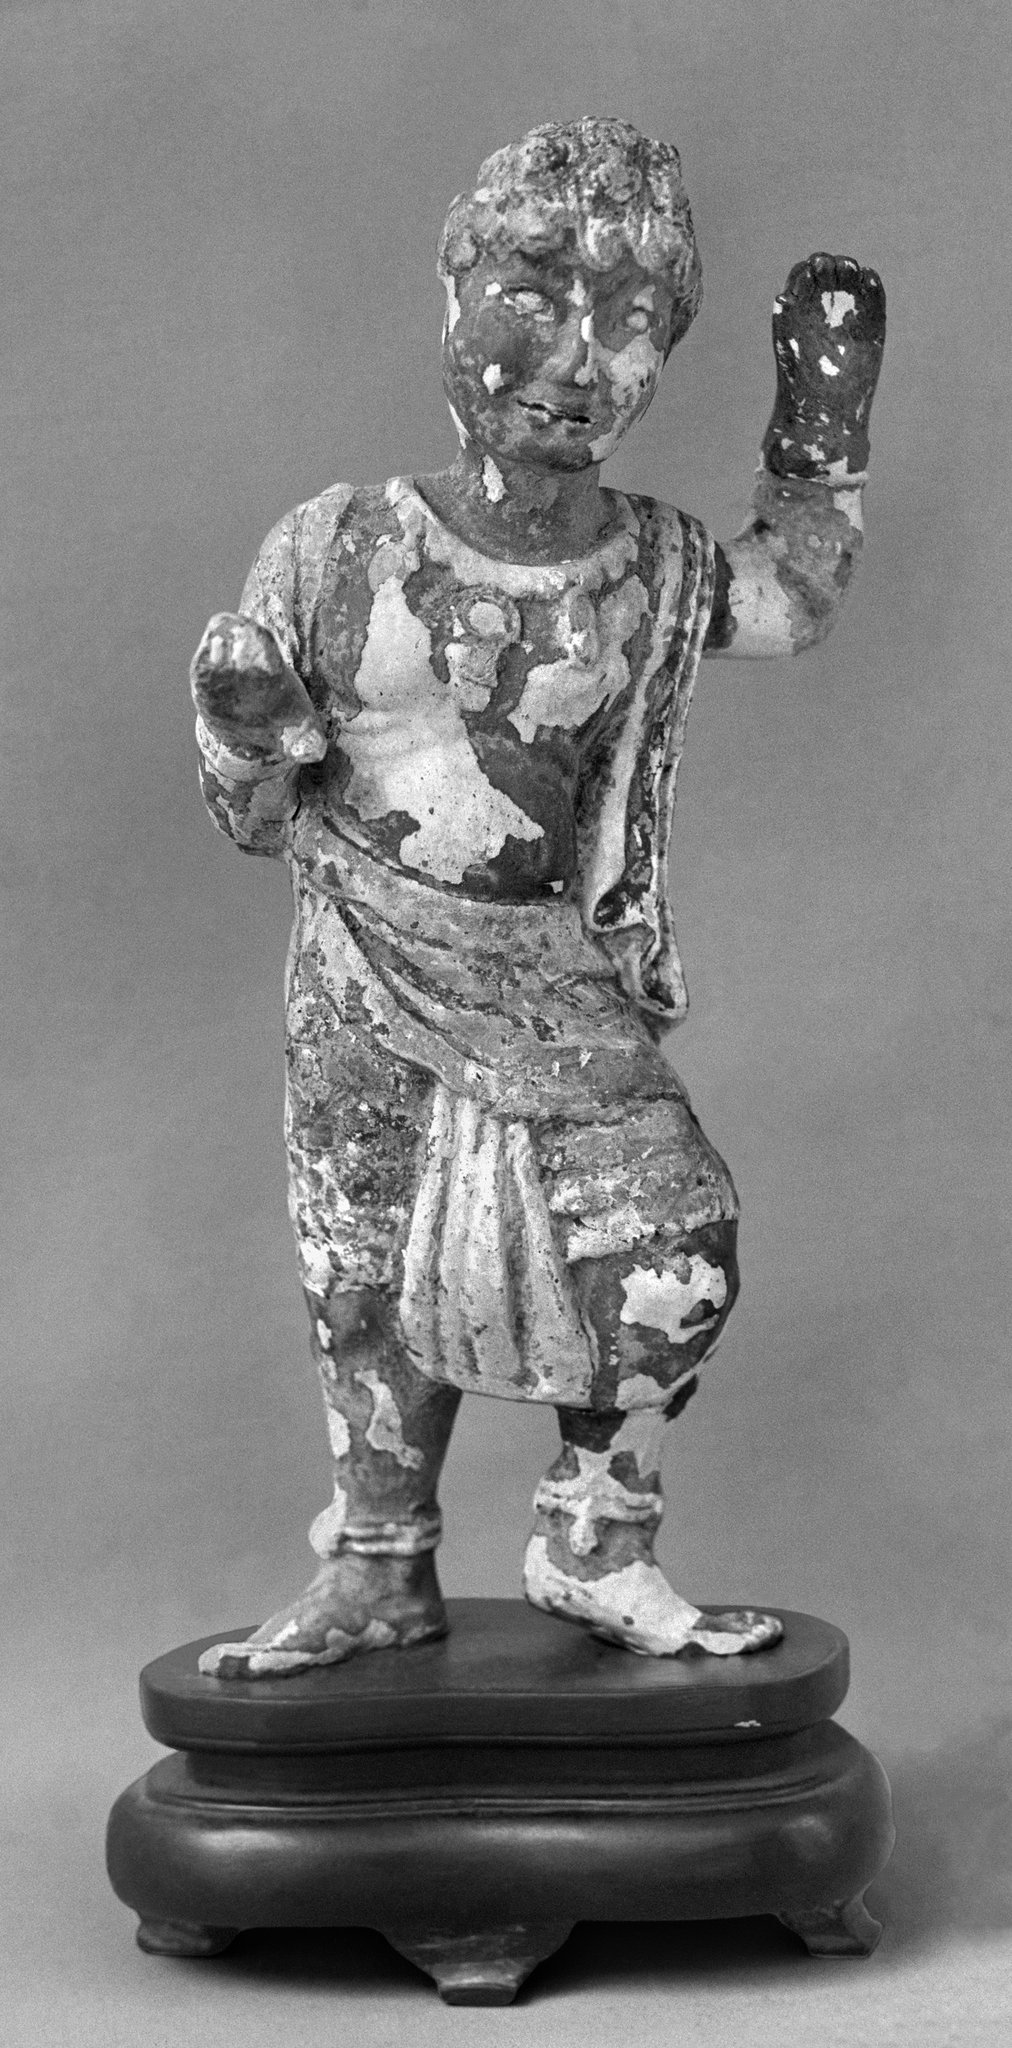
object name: figure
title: Figure of a dancer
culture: chinese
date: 601-800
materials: pigment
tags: dancers